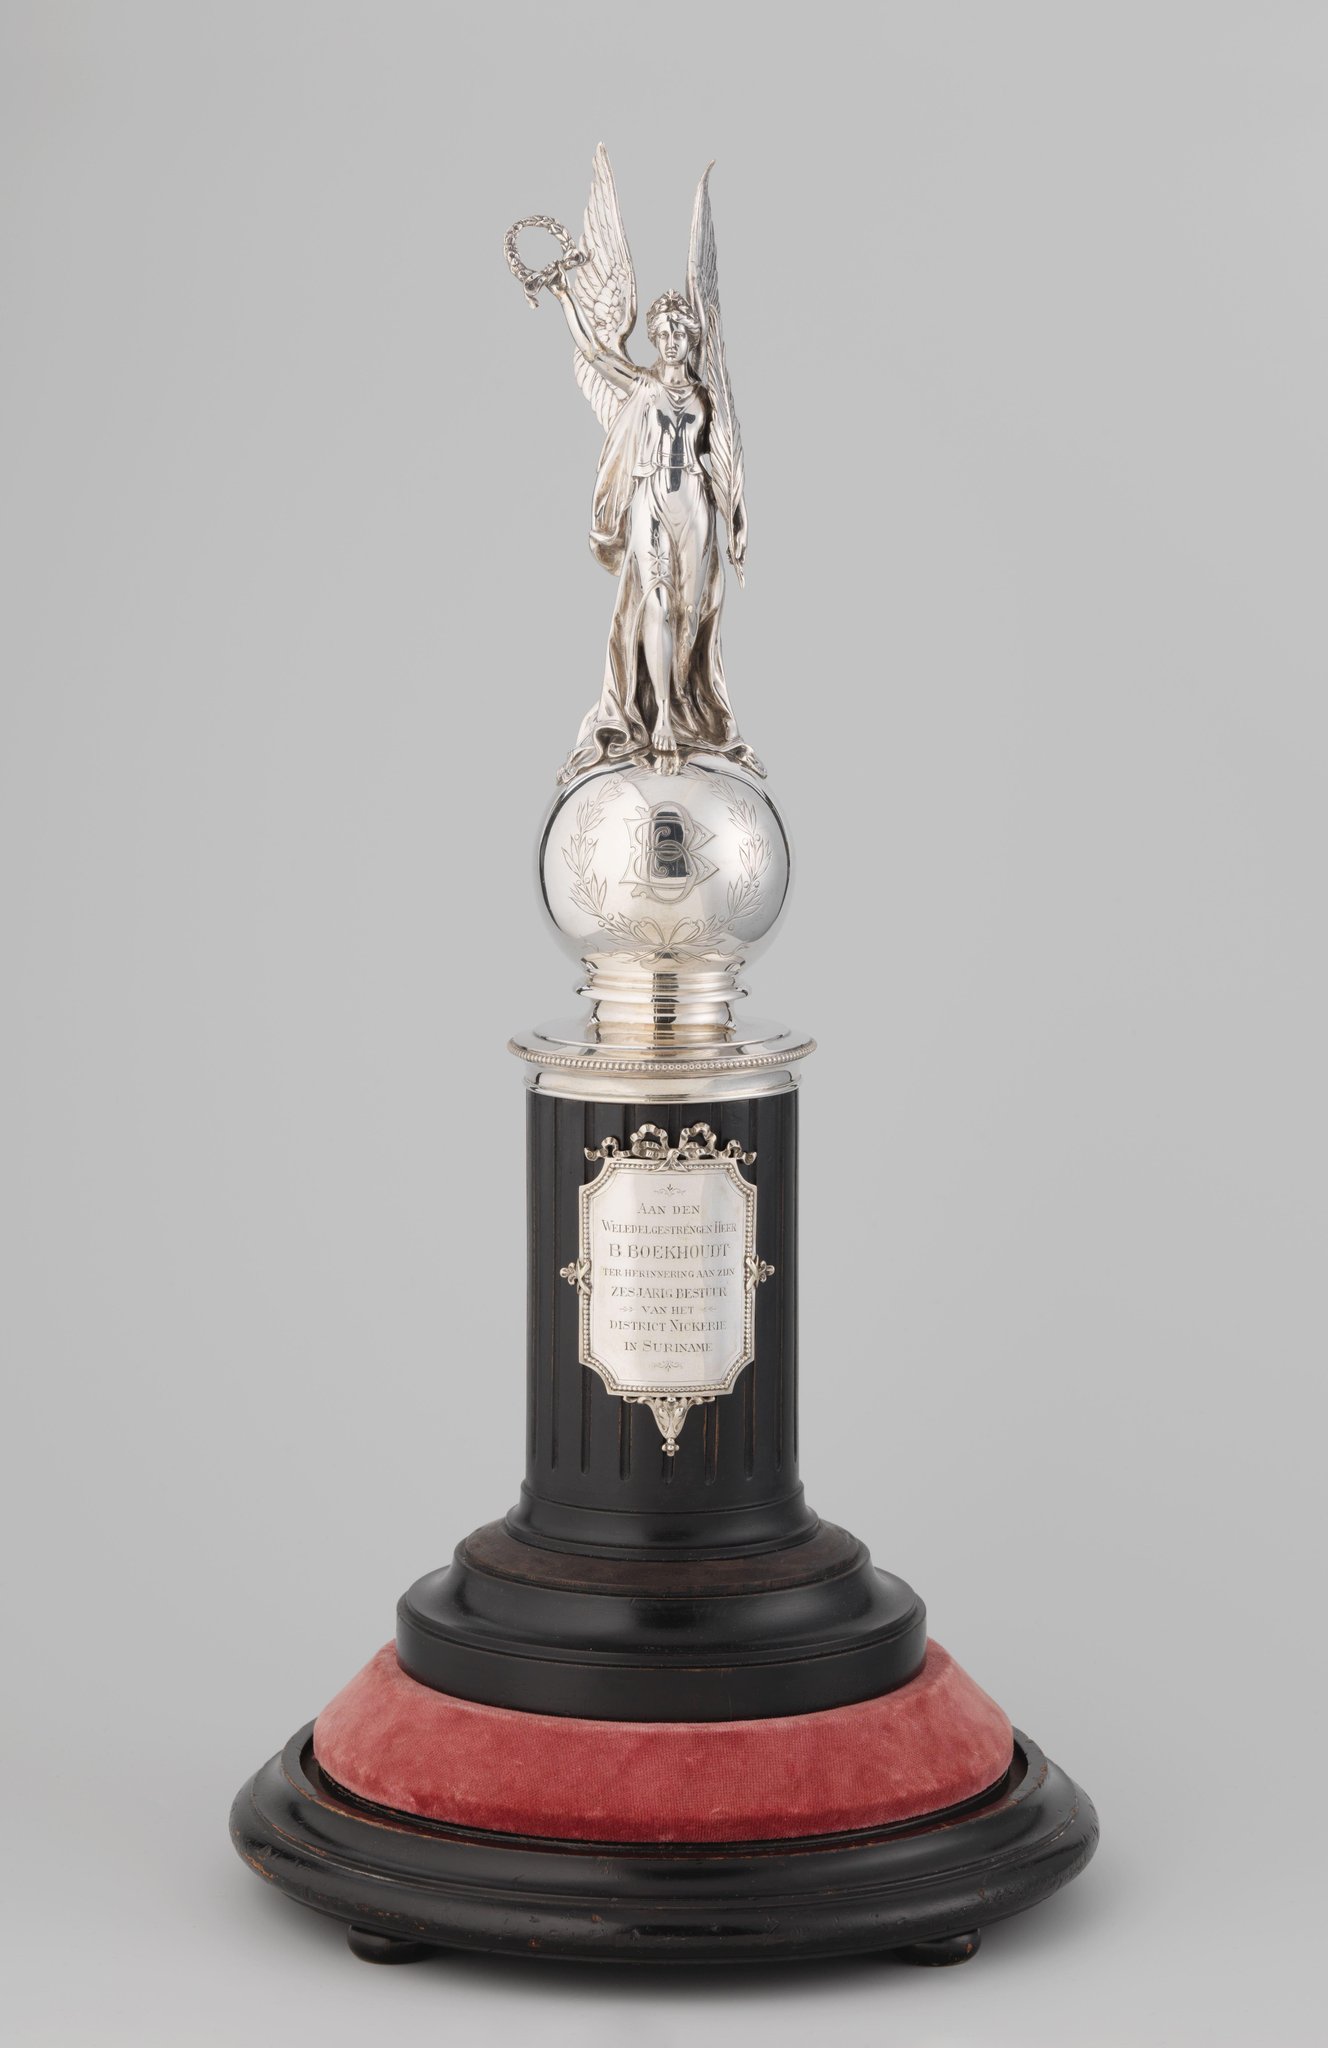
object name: pedestal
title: Sokkel van het gedenkstuk voor B. Boekhoudt, districts-commissaris van Nickerie in Suriname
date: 1909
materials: silver, wood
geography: the hague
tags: bernardus boekhoudt, nickerie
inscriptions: inscription: ‘Aan den weleldelgestrengen heer B. Boekhoudt ter herinnering aan zijn zesjarig bestuur van het district Nickerie in Suriname’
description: Dit beeld staat op een ronde houten sokkel waarop een zilveren plaatje is gemonteerd met de tekst: Aan den weleldelgestrengen heer B. Boekhoudt ter herinnering aan zijn zesjarig bestuur van het district Nickerie in Suriname.